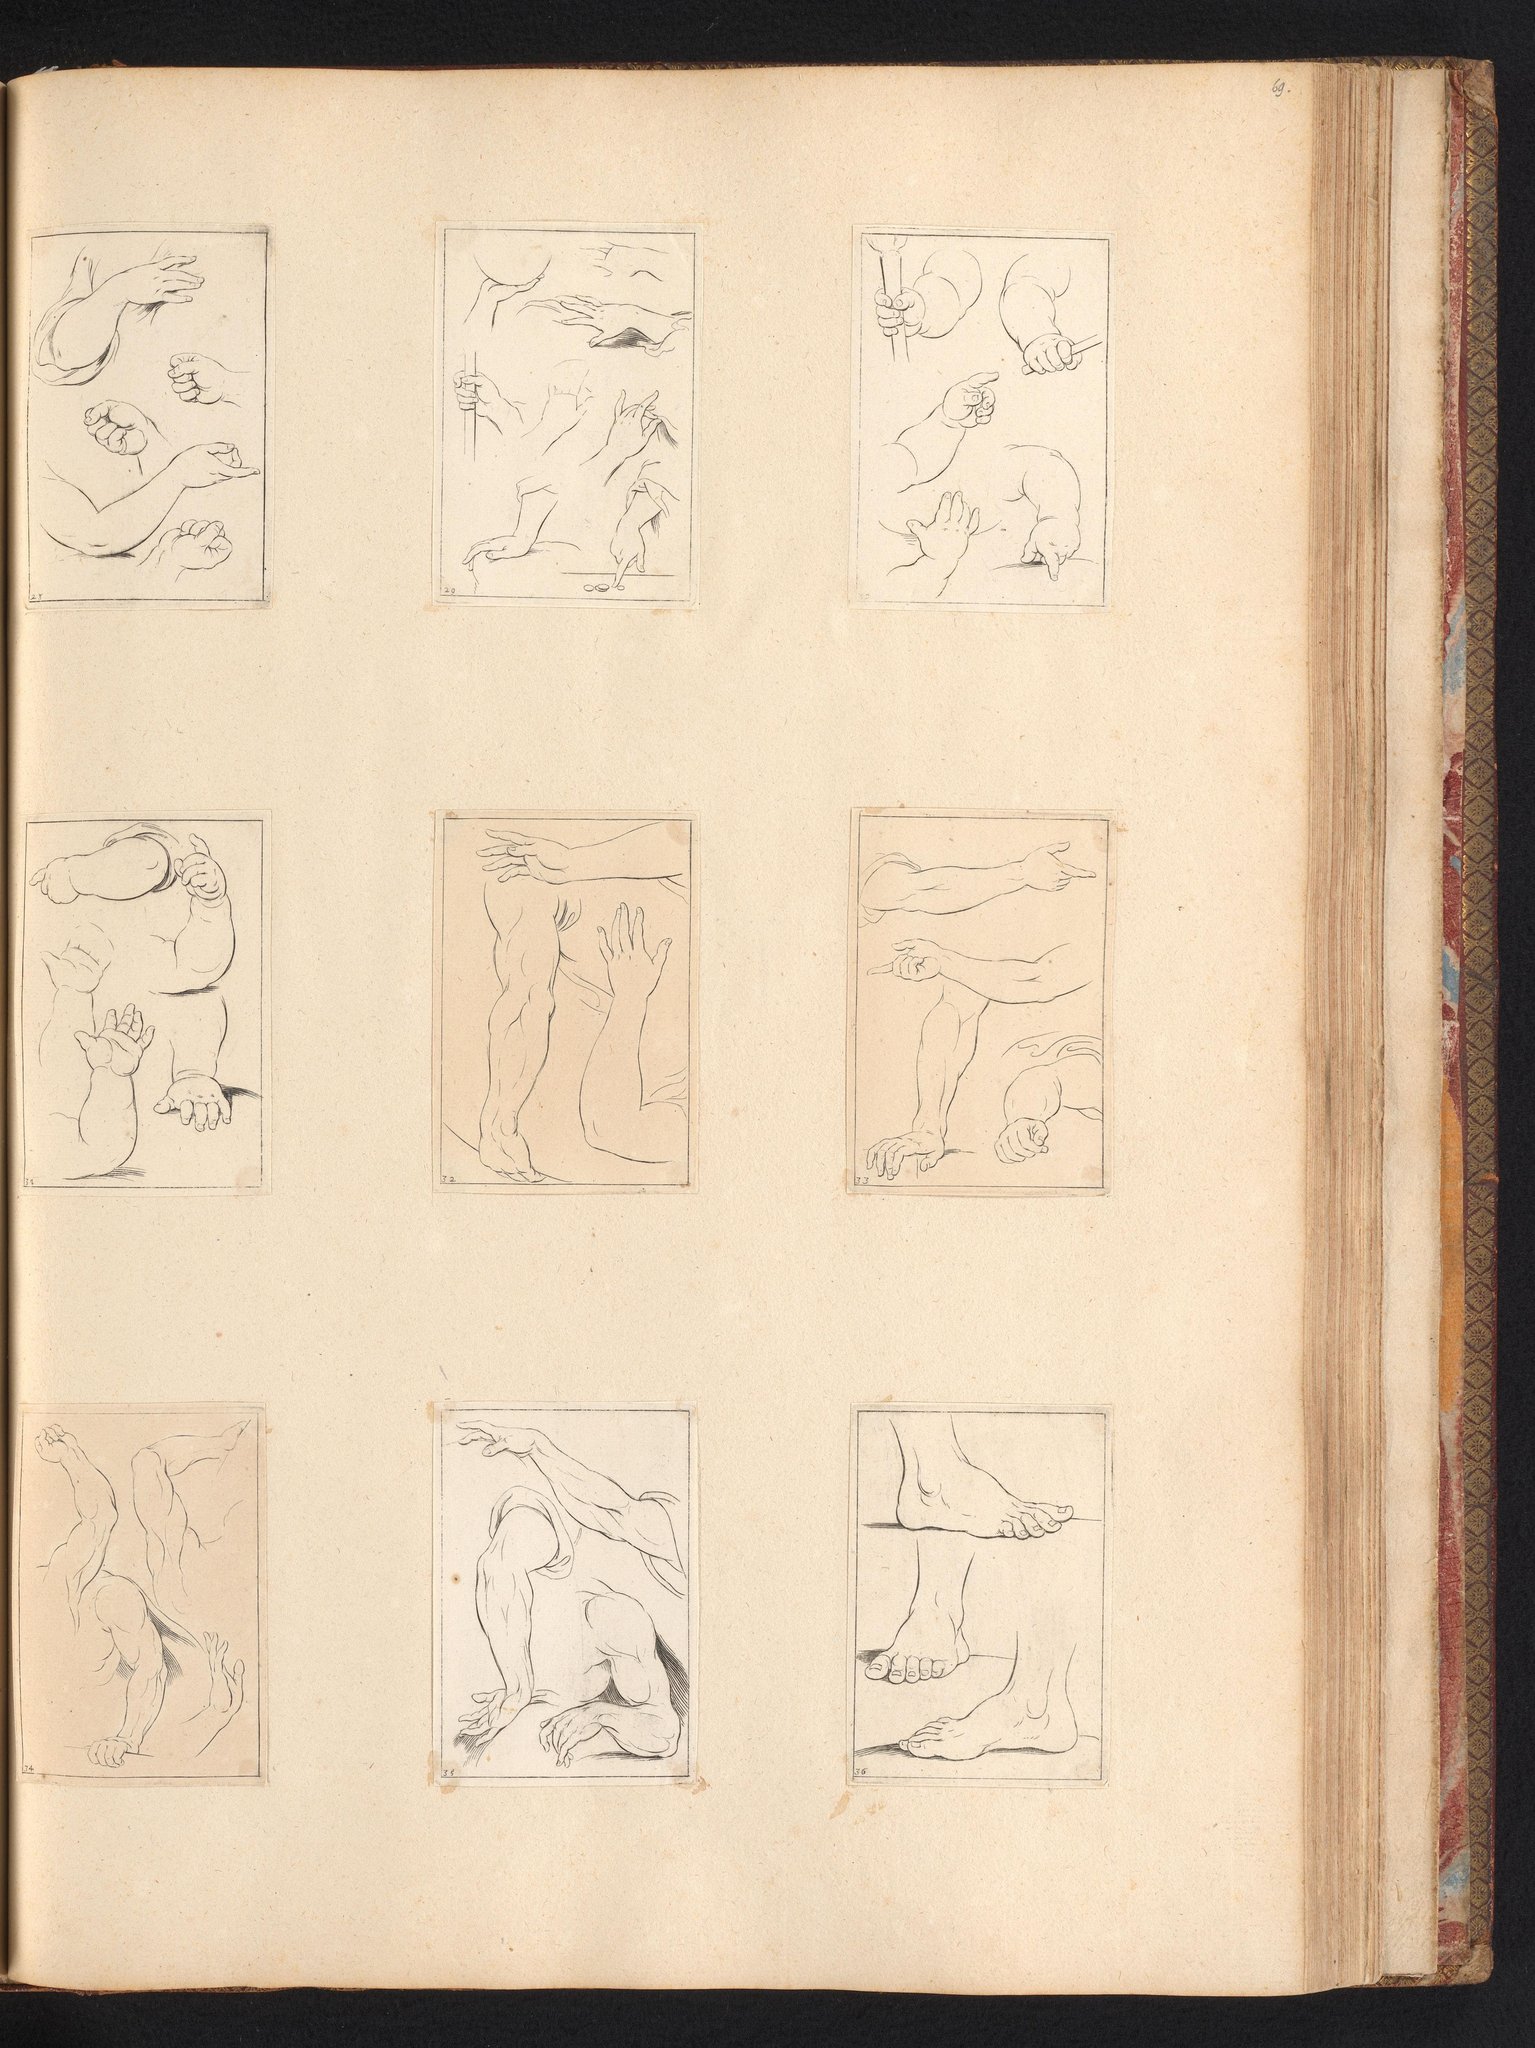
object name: album leaf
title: Principes de dessein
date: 1700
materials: paper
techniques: engraving, etching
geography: france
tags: model-books ~ implements of painter, tools, implements of draughtsman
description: Negen tekenvoorbeelden van handen, armen en voeten van mannen, vrouwen en kinderen. Alle negen prenten zijn linksonder genummerd van 28 t/m 36. Deze negen prenten maken deel uit van een album.